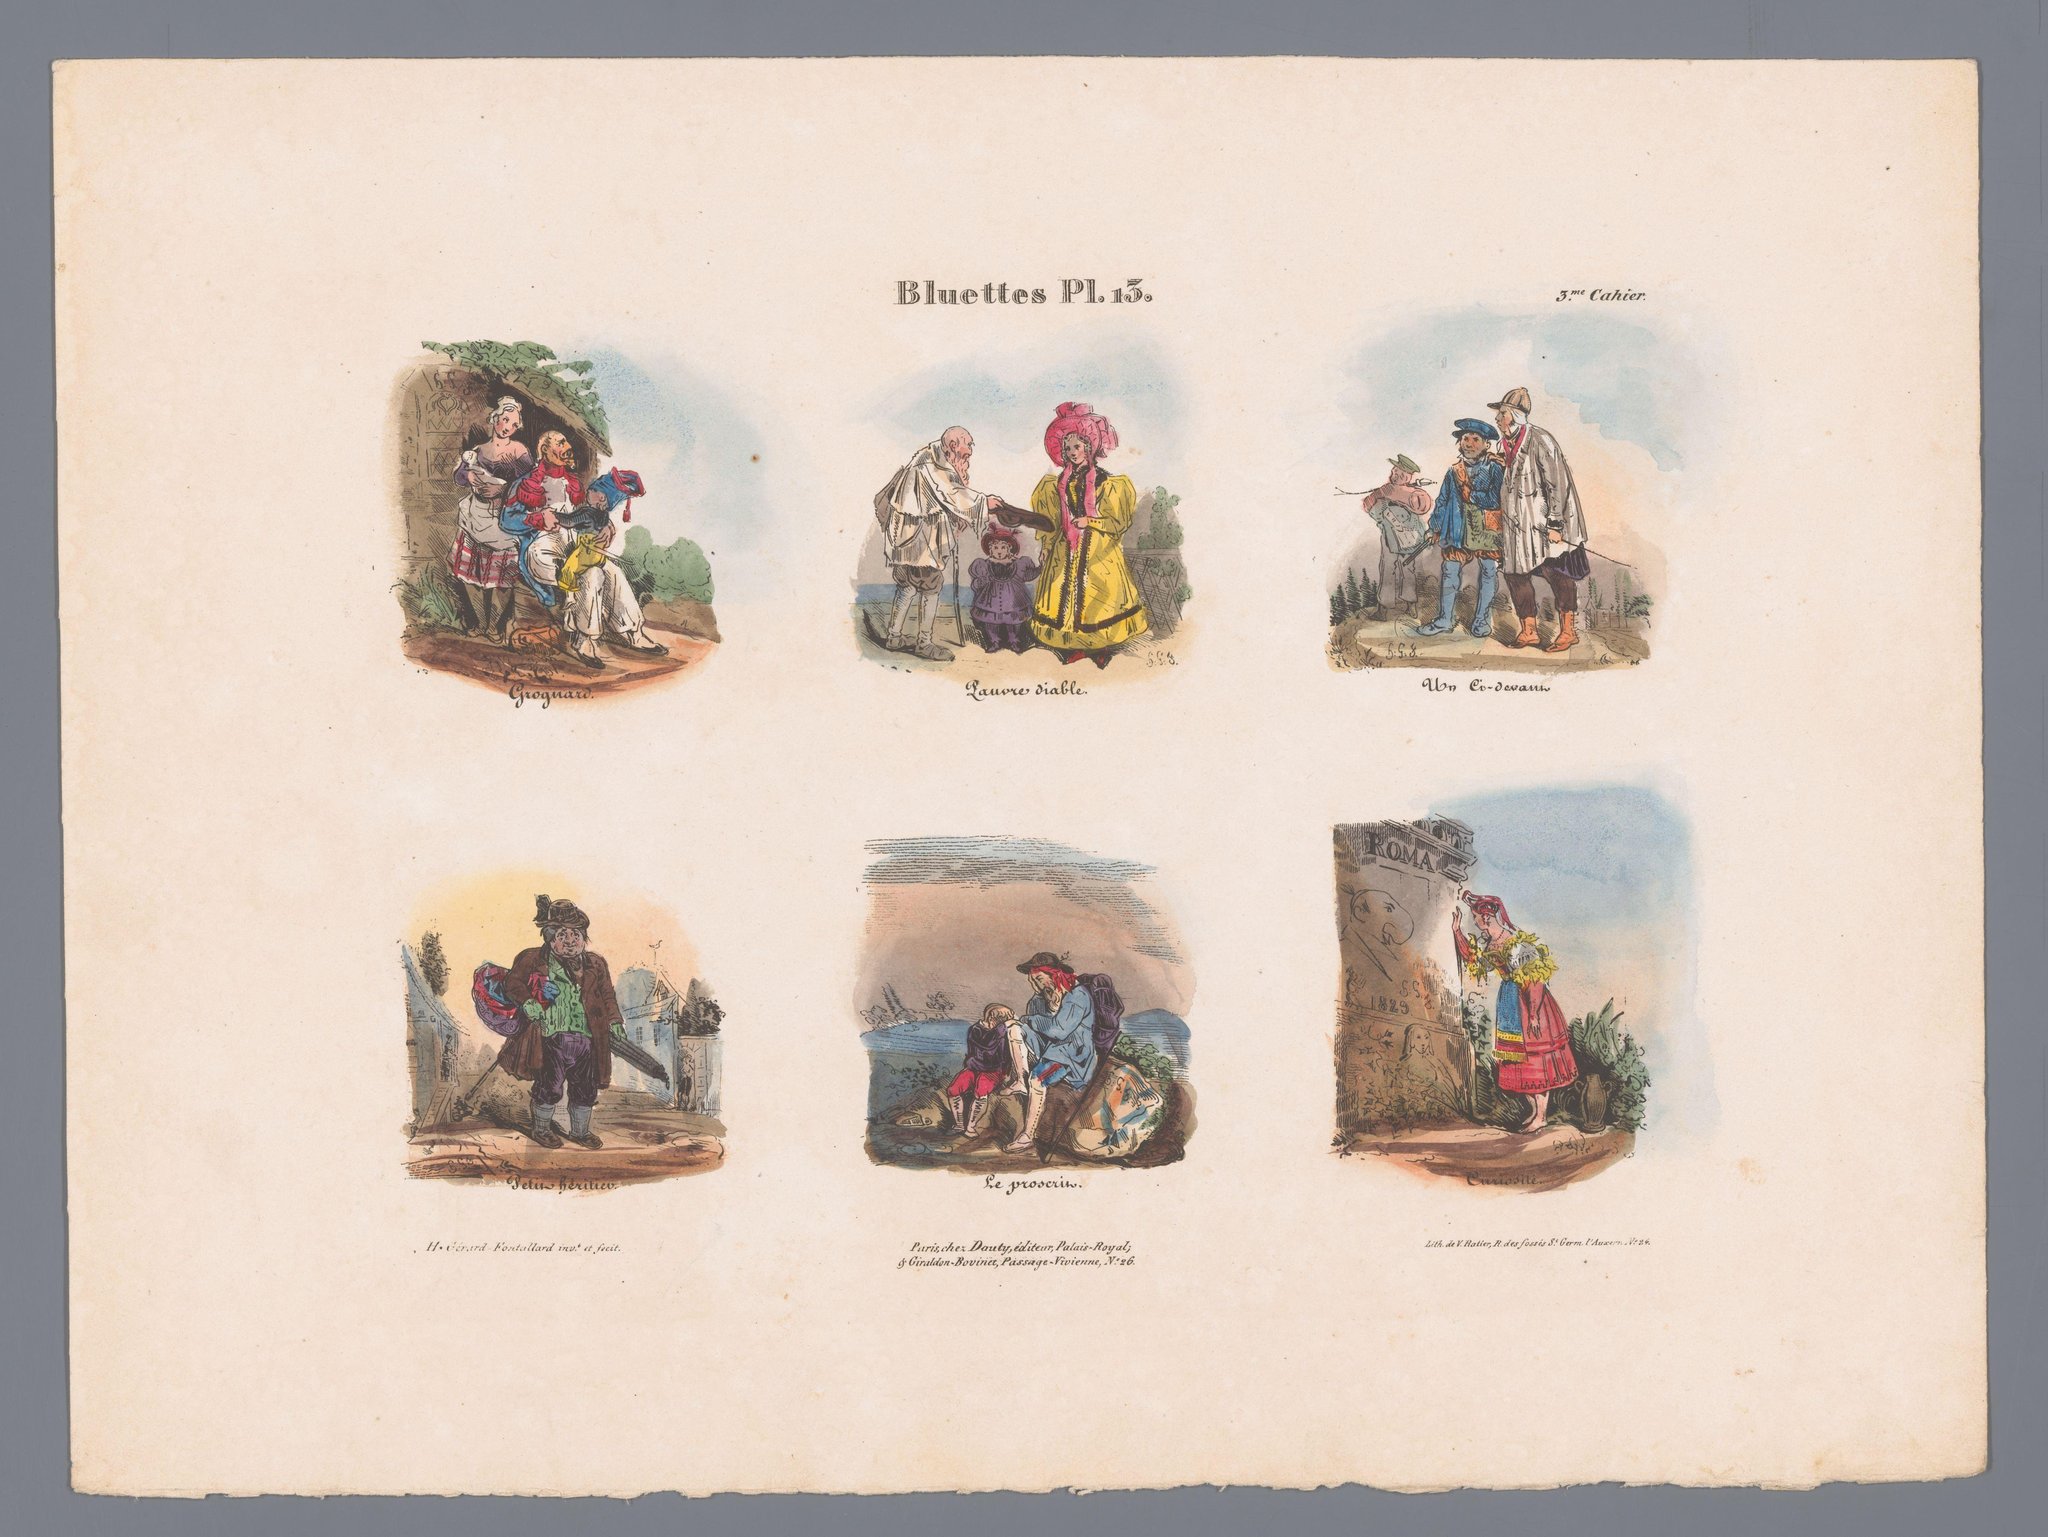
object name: print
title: Zes scènes met diverse personen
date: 1829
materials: paper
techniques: hand coloring, lithograph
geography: paris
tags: various human types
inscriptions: collector's mark: Lugt 2228a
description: Prent maakt deel uit van een omslag met achttien prenten.